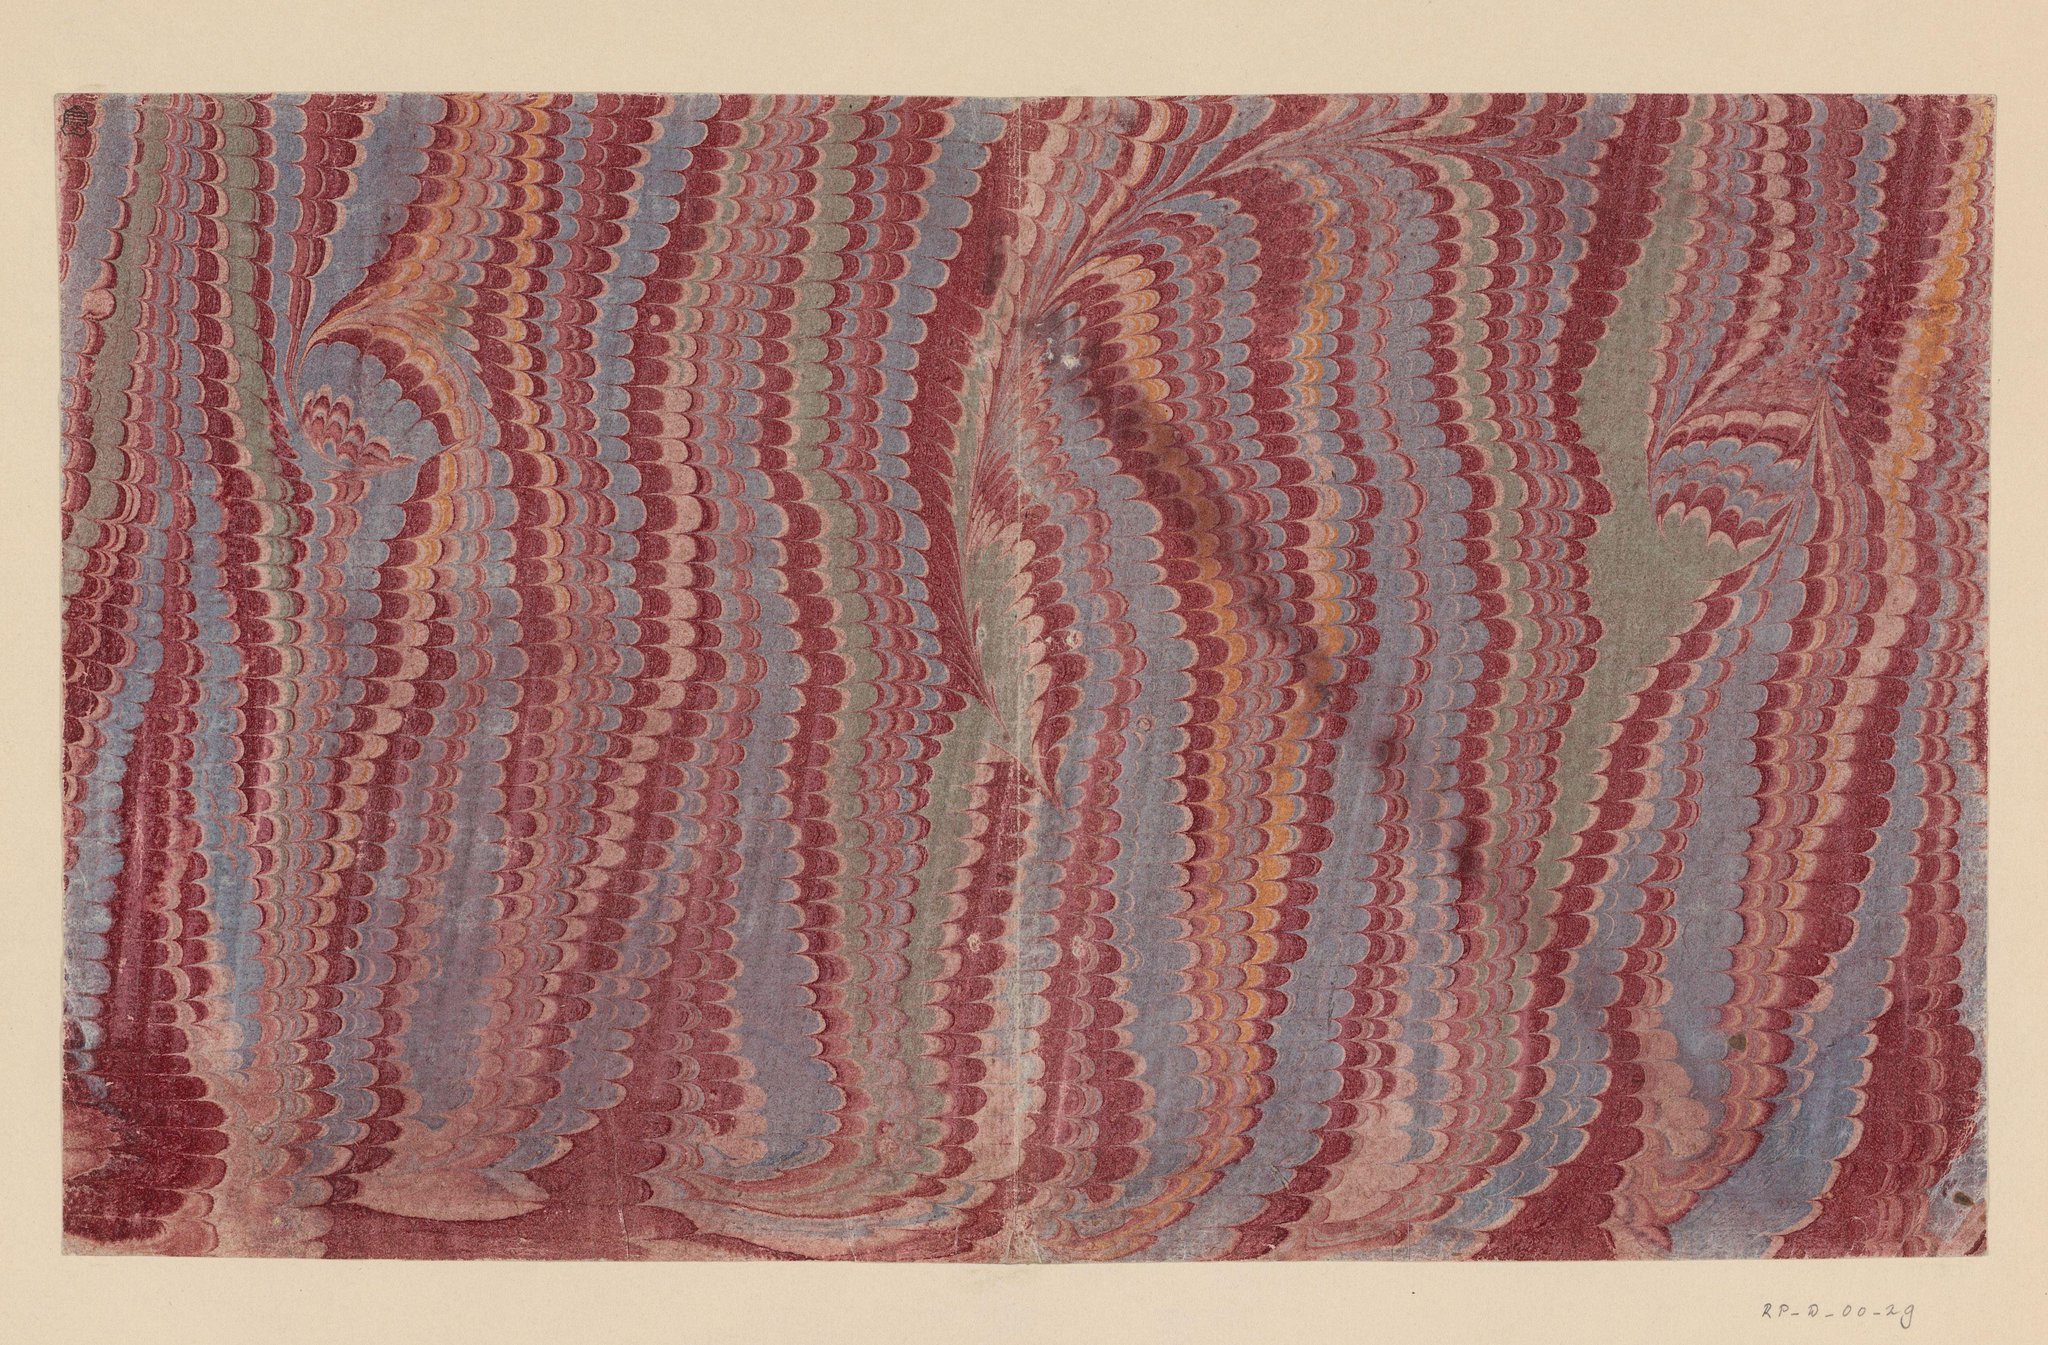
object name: marbled paper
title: Spiraalkammarmering in rood, geel, blauw en groen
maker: Anonymous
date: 1700-1850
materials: paint, paper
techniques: marbled paper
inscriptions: collector's mark: Lugt 2760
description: Spiraalkammarmering in rood, geel, blauw en groen. Gebruikt als omslag.